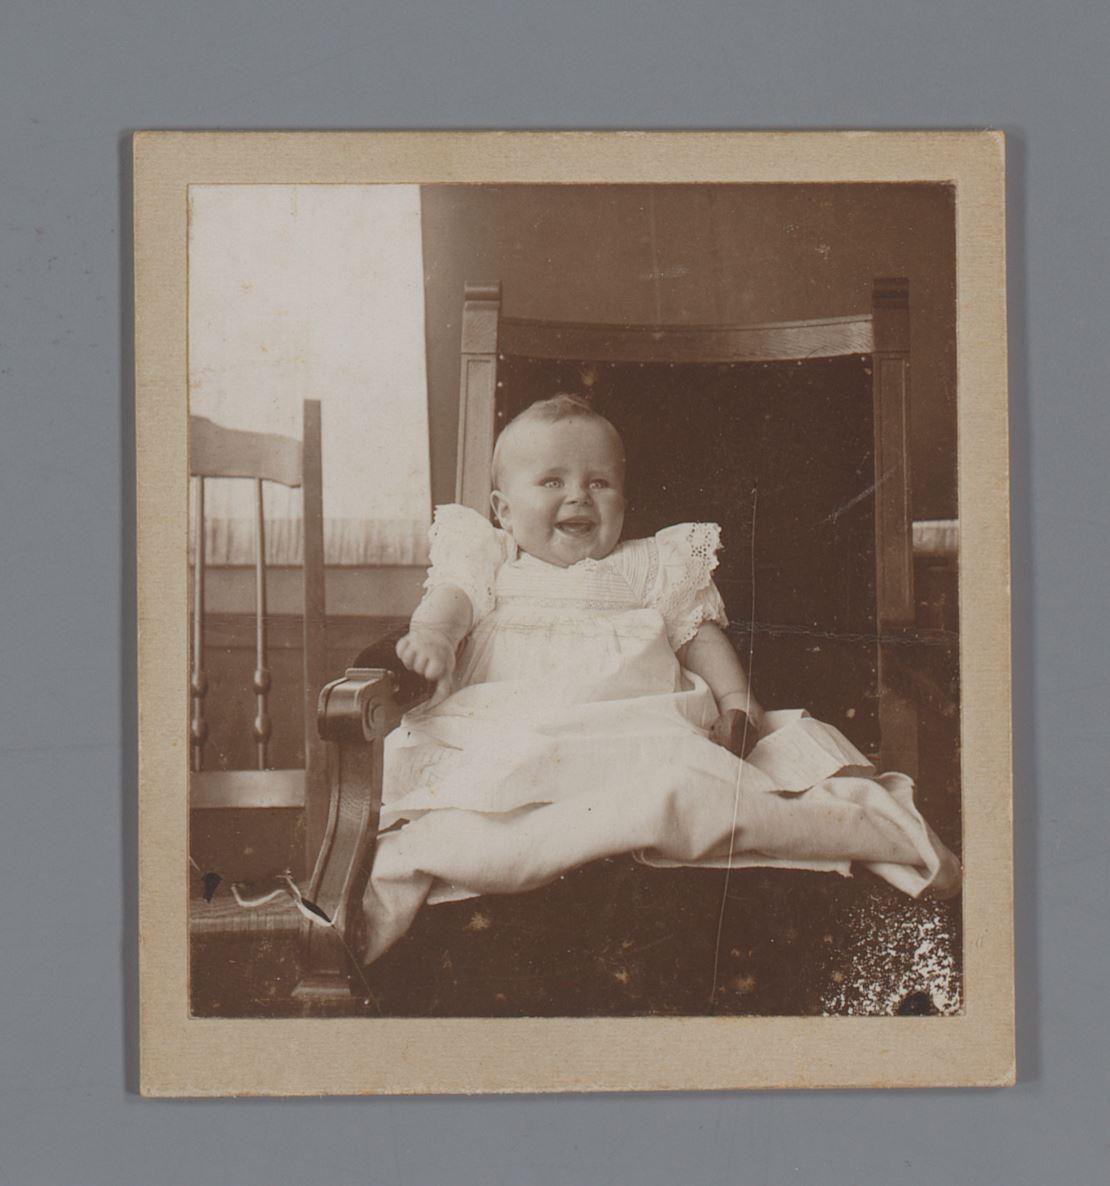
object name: photograph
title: Portret van een kind in een stoel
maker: johannes diderik van der waals (1873-1971)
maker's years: 1873-1971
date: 1900-1920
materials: cardboard, photographic support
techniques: collodion silver print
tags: historical persons - bb - woman, chair